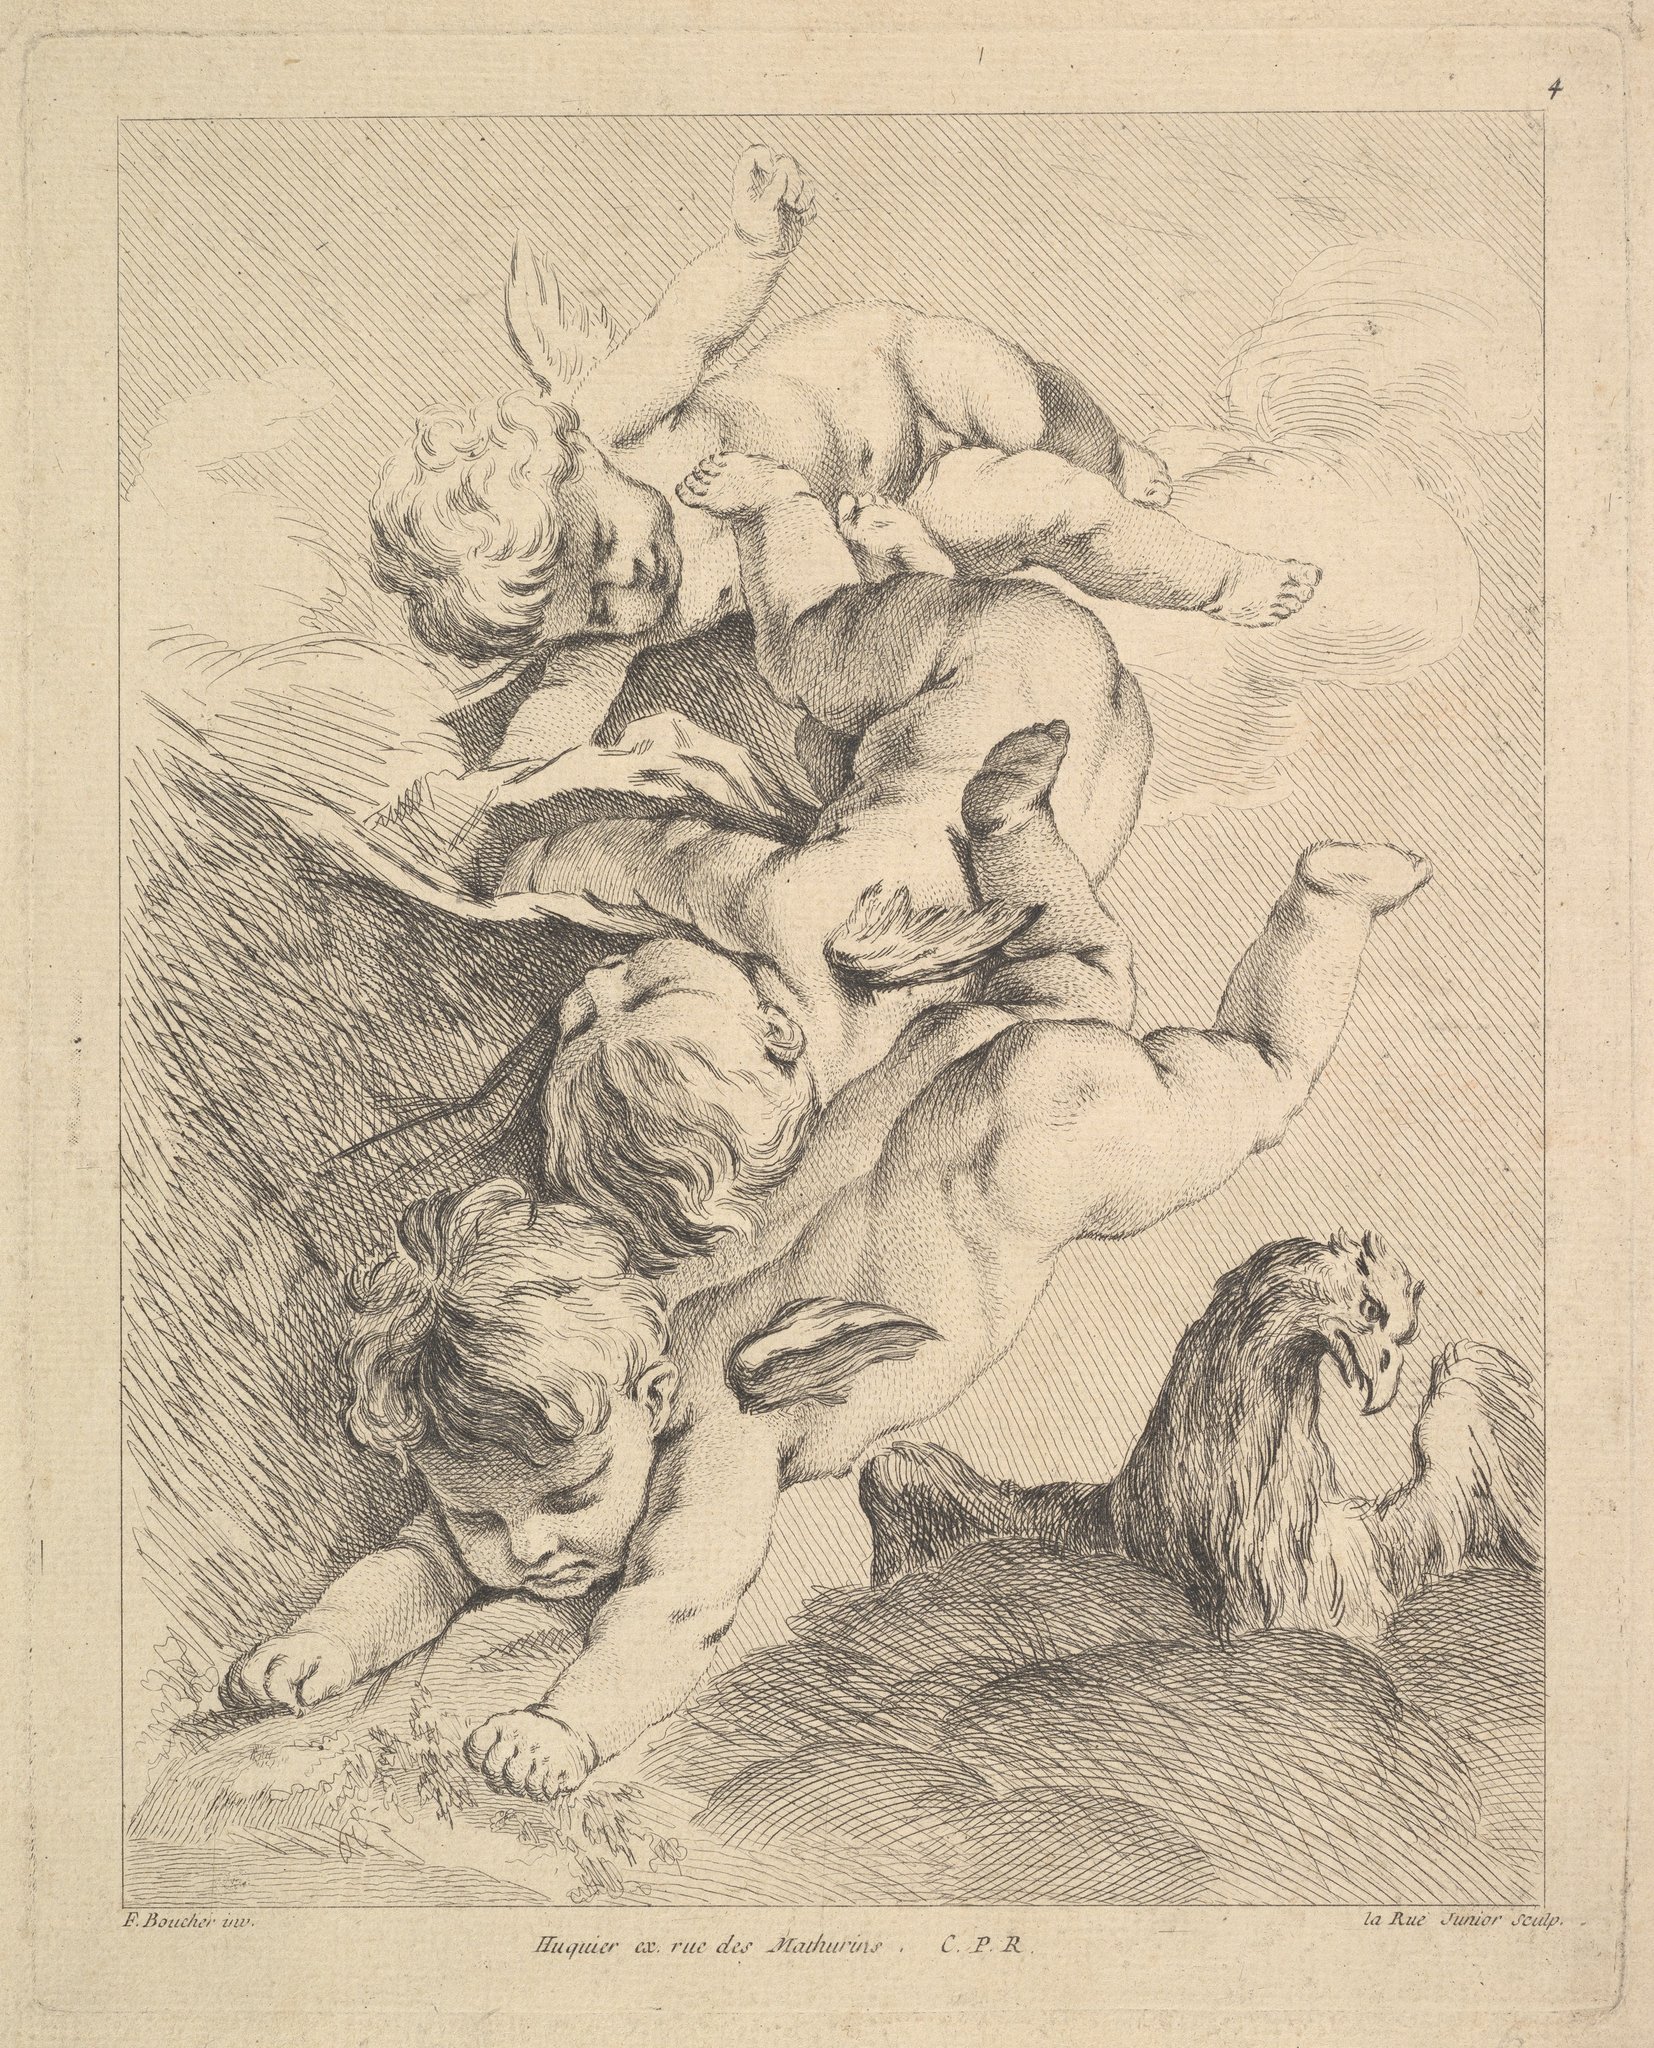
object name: print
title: Three Cupids Turning a Somersault, an Eagle on the Right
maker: louis félix de la rue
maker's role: artist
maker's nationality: french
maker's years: 1731-1765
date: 1731-1765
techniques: engraving, etching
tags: eagles,cupid